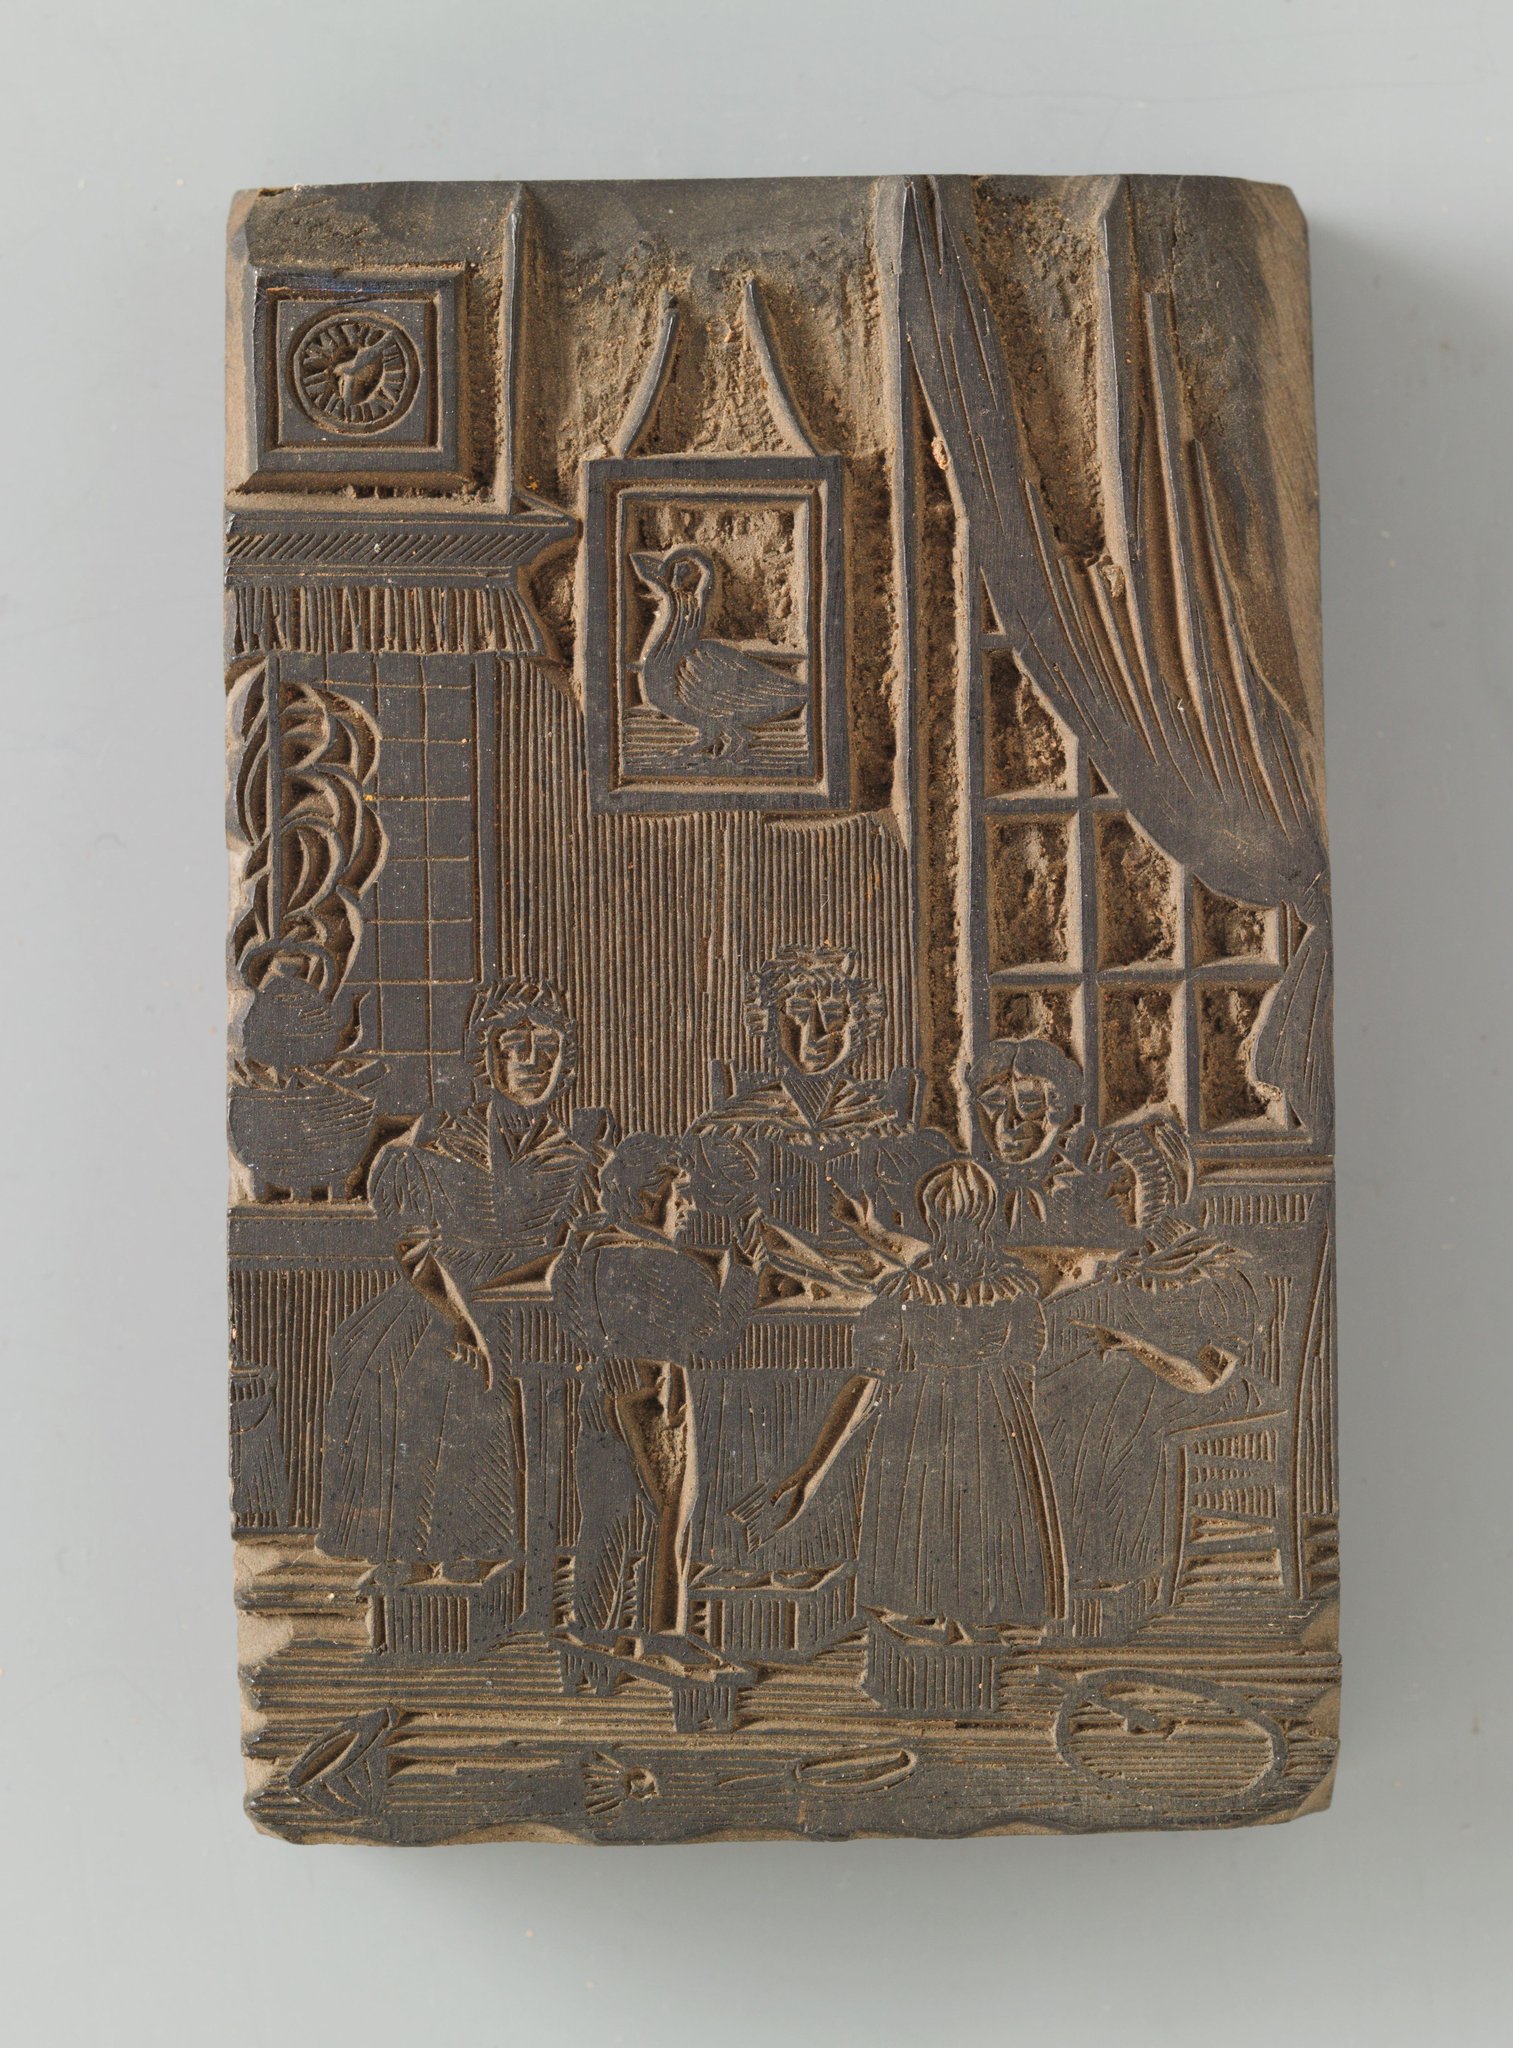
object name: wood block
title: Gezin rond een tafel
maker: Anonymous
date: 1700-1899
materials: wood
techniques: woodcut